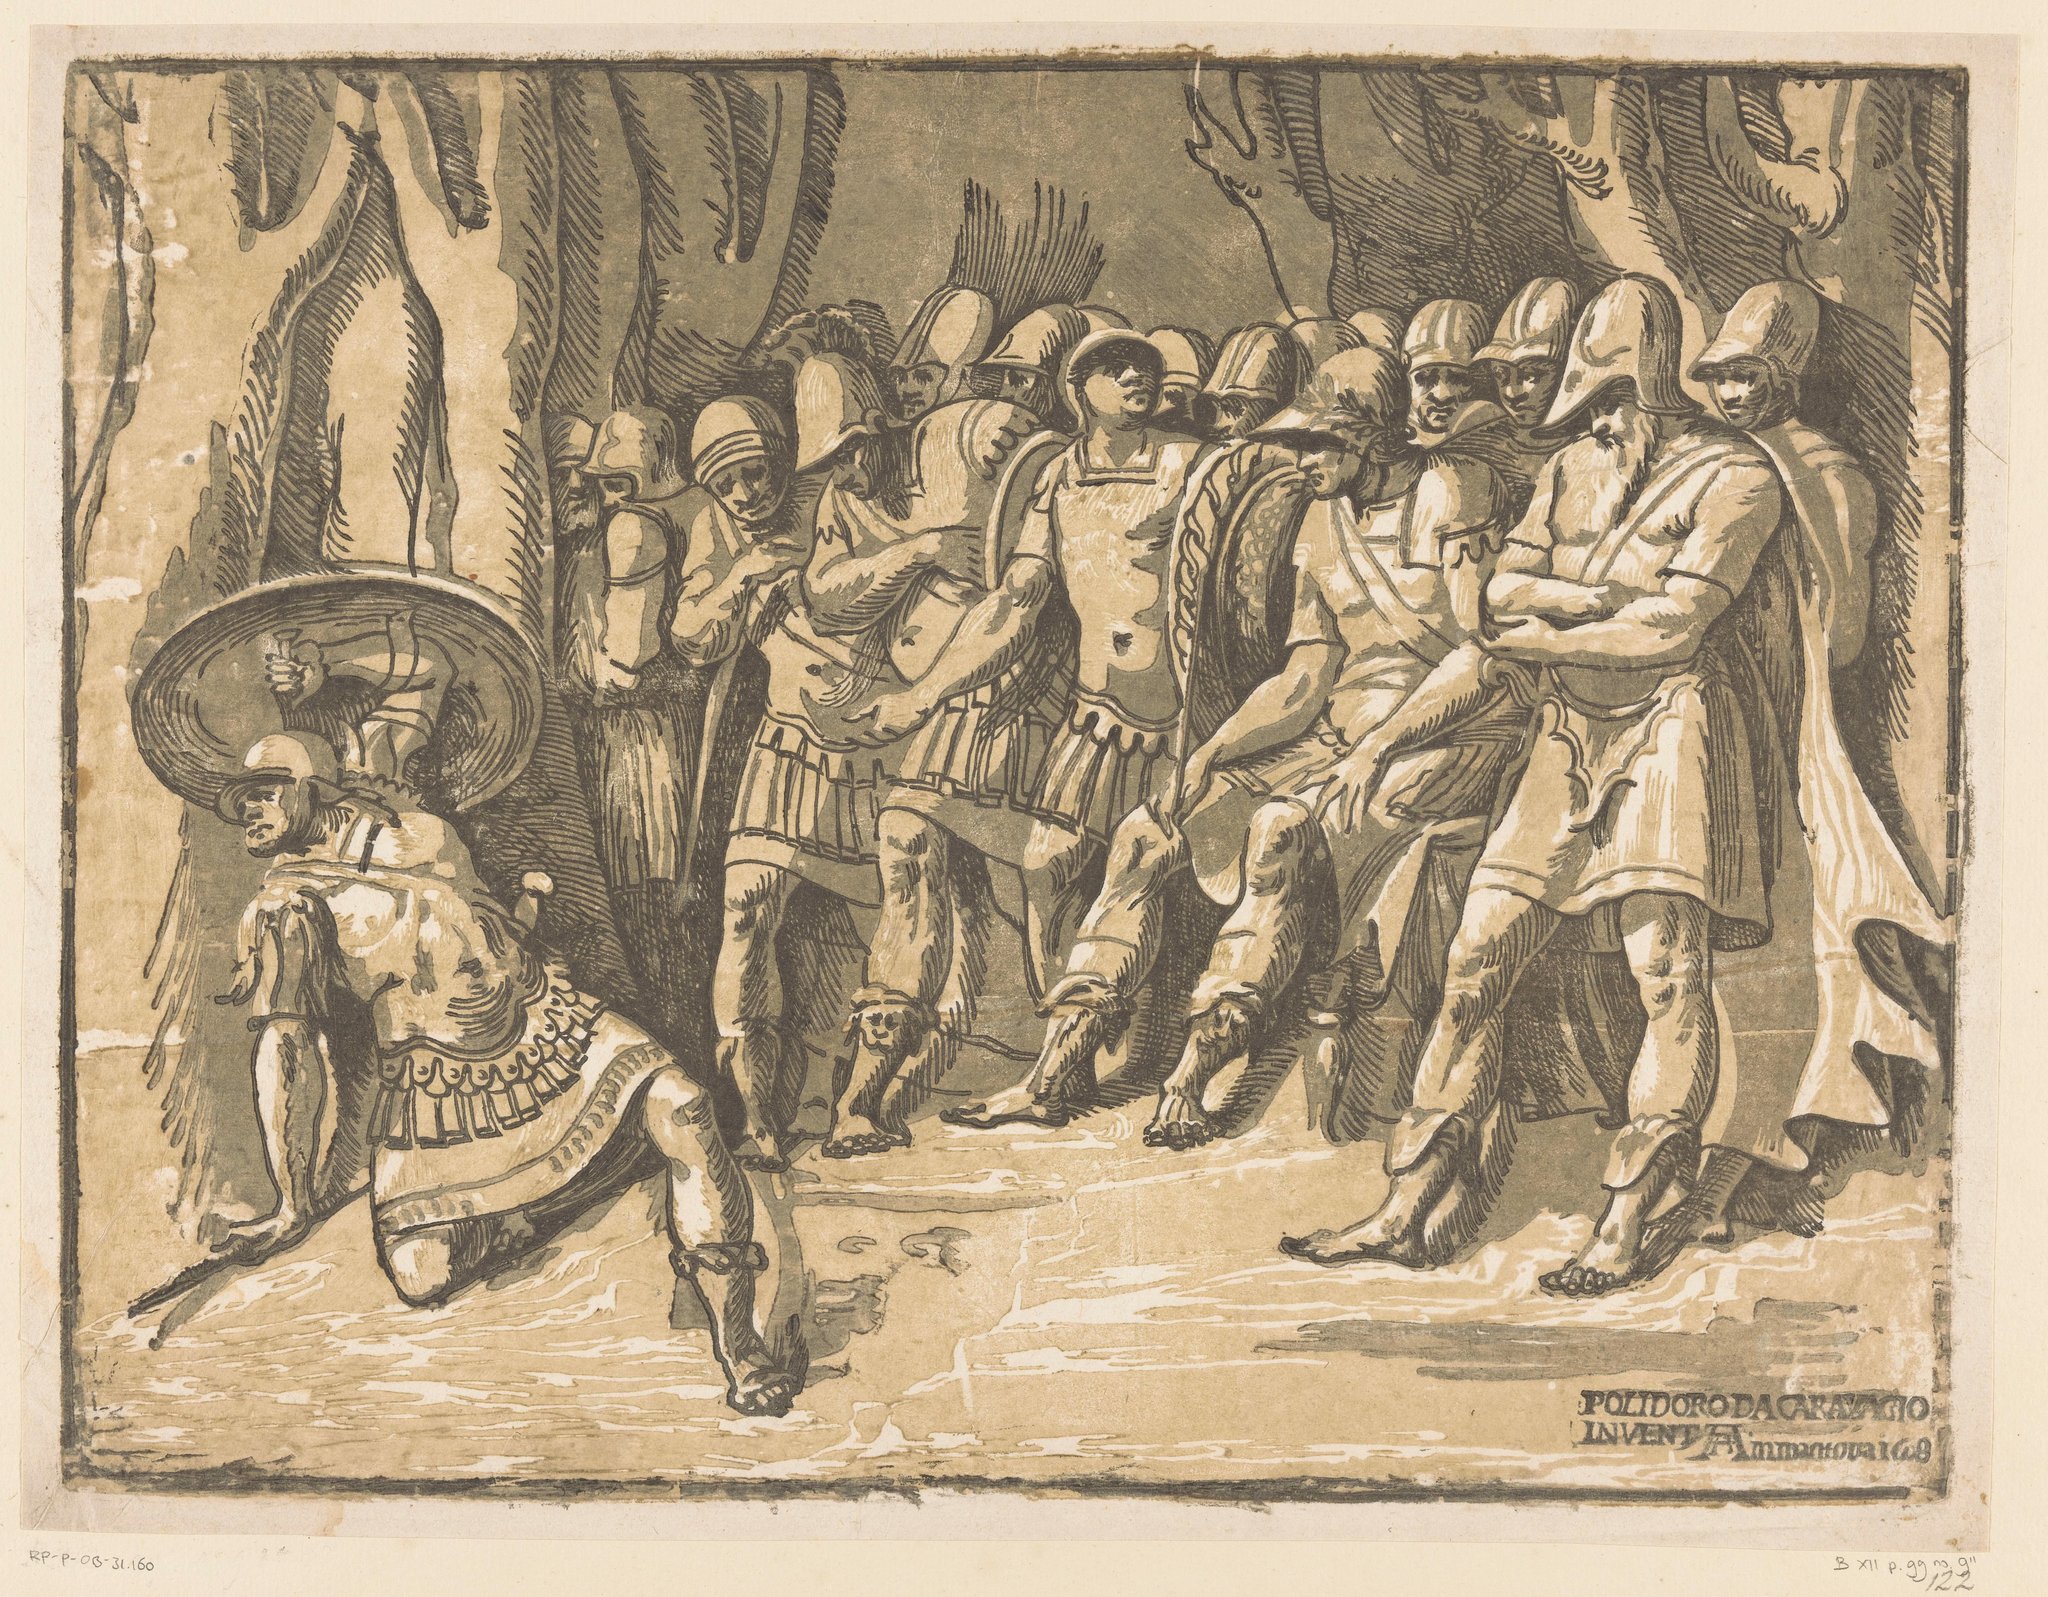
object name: print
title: Zelfmoord van Ajax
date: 1608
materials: paper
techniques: woodcut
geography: italy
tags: agamemnon, suicide of ajax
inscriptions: collector's mark: Lugt 240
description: Nadat Ajax de strijd om de wapens van Achilles heeft verloren stort hij zich in zijn eigen zwaard. Rechts de toekijkende koning Agamemnon en een groep soldaten.